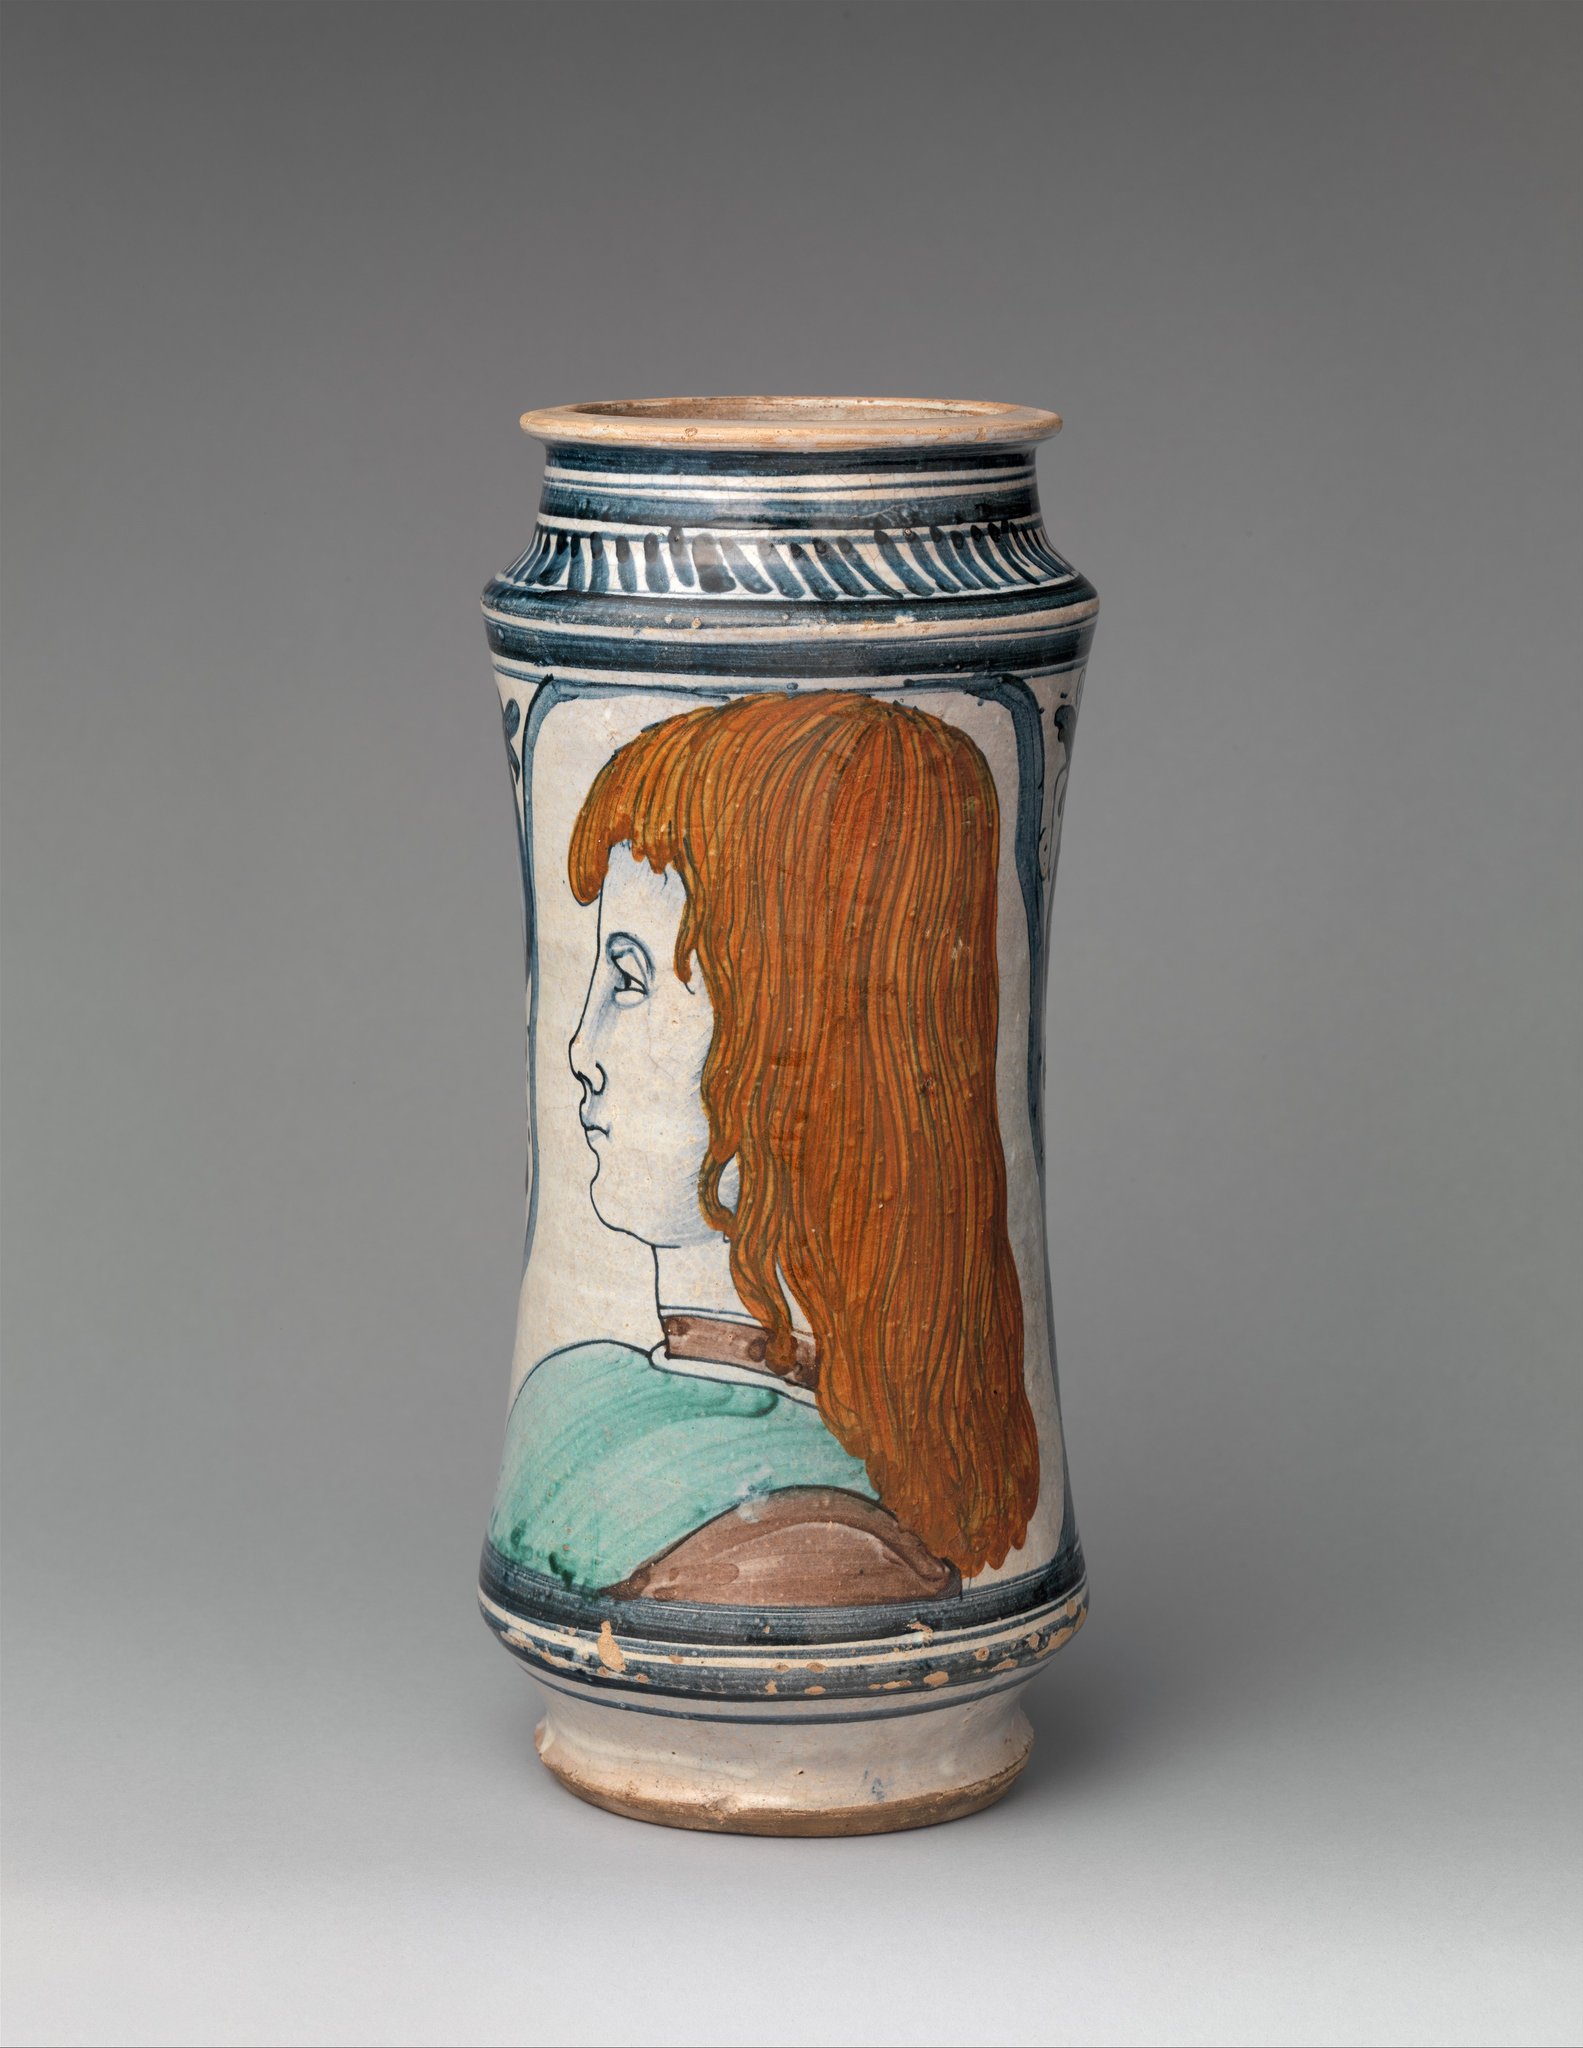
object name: pharmacy jar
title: Pharmacy jar (albarello)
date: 1475-1500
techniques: maiolica, glazing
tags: men,profiles